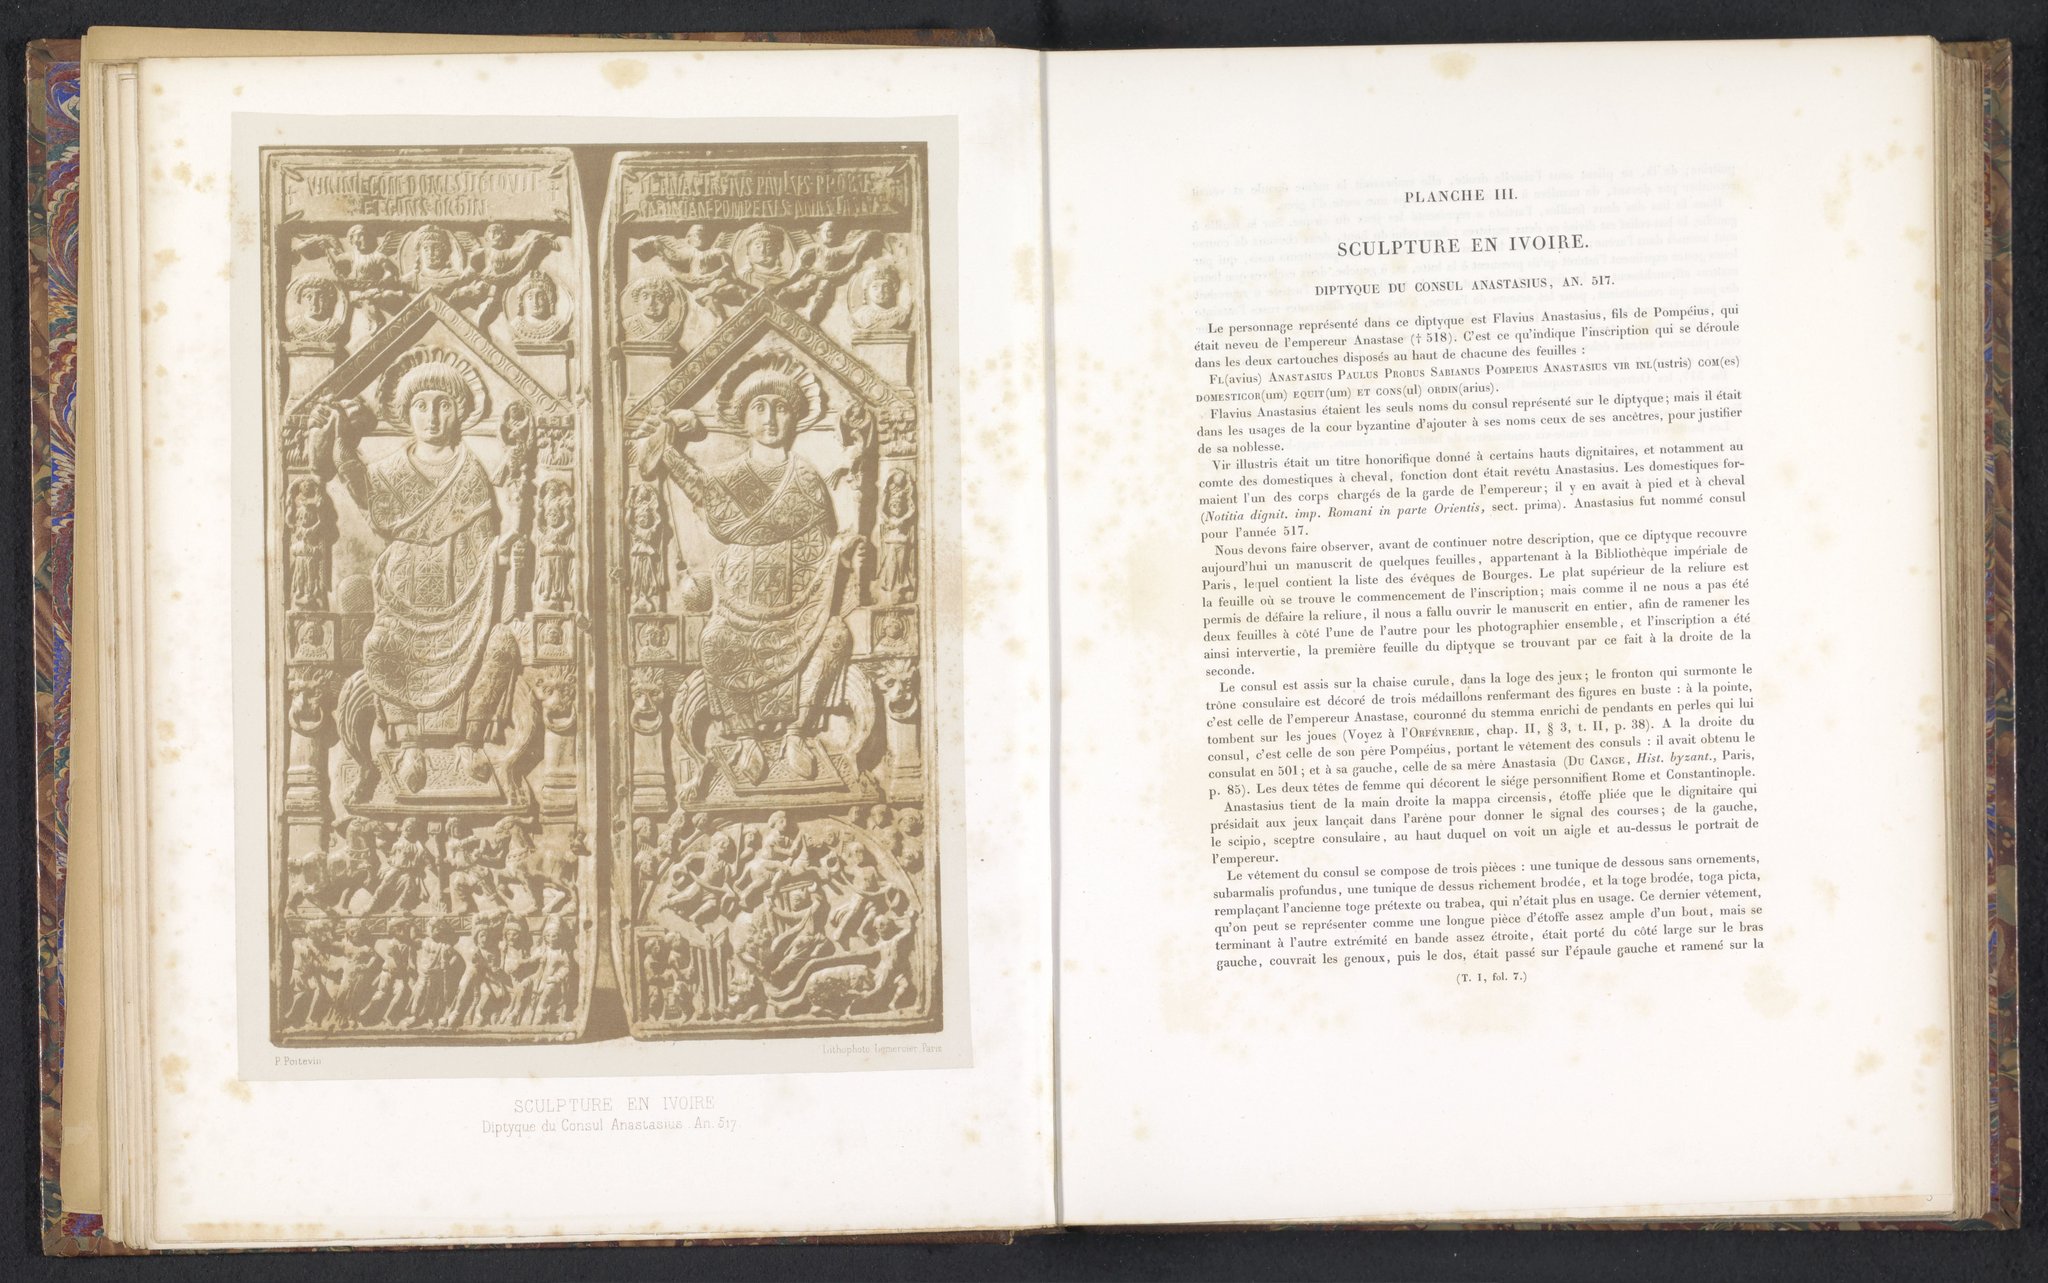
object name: photomechanical print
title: Sculpture en ivoire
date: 1859-1864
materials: paper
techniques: photolithography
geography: paris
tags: ruler, sovereign, sculpture (+ relief ~ sculpture)